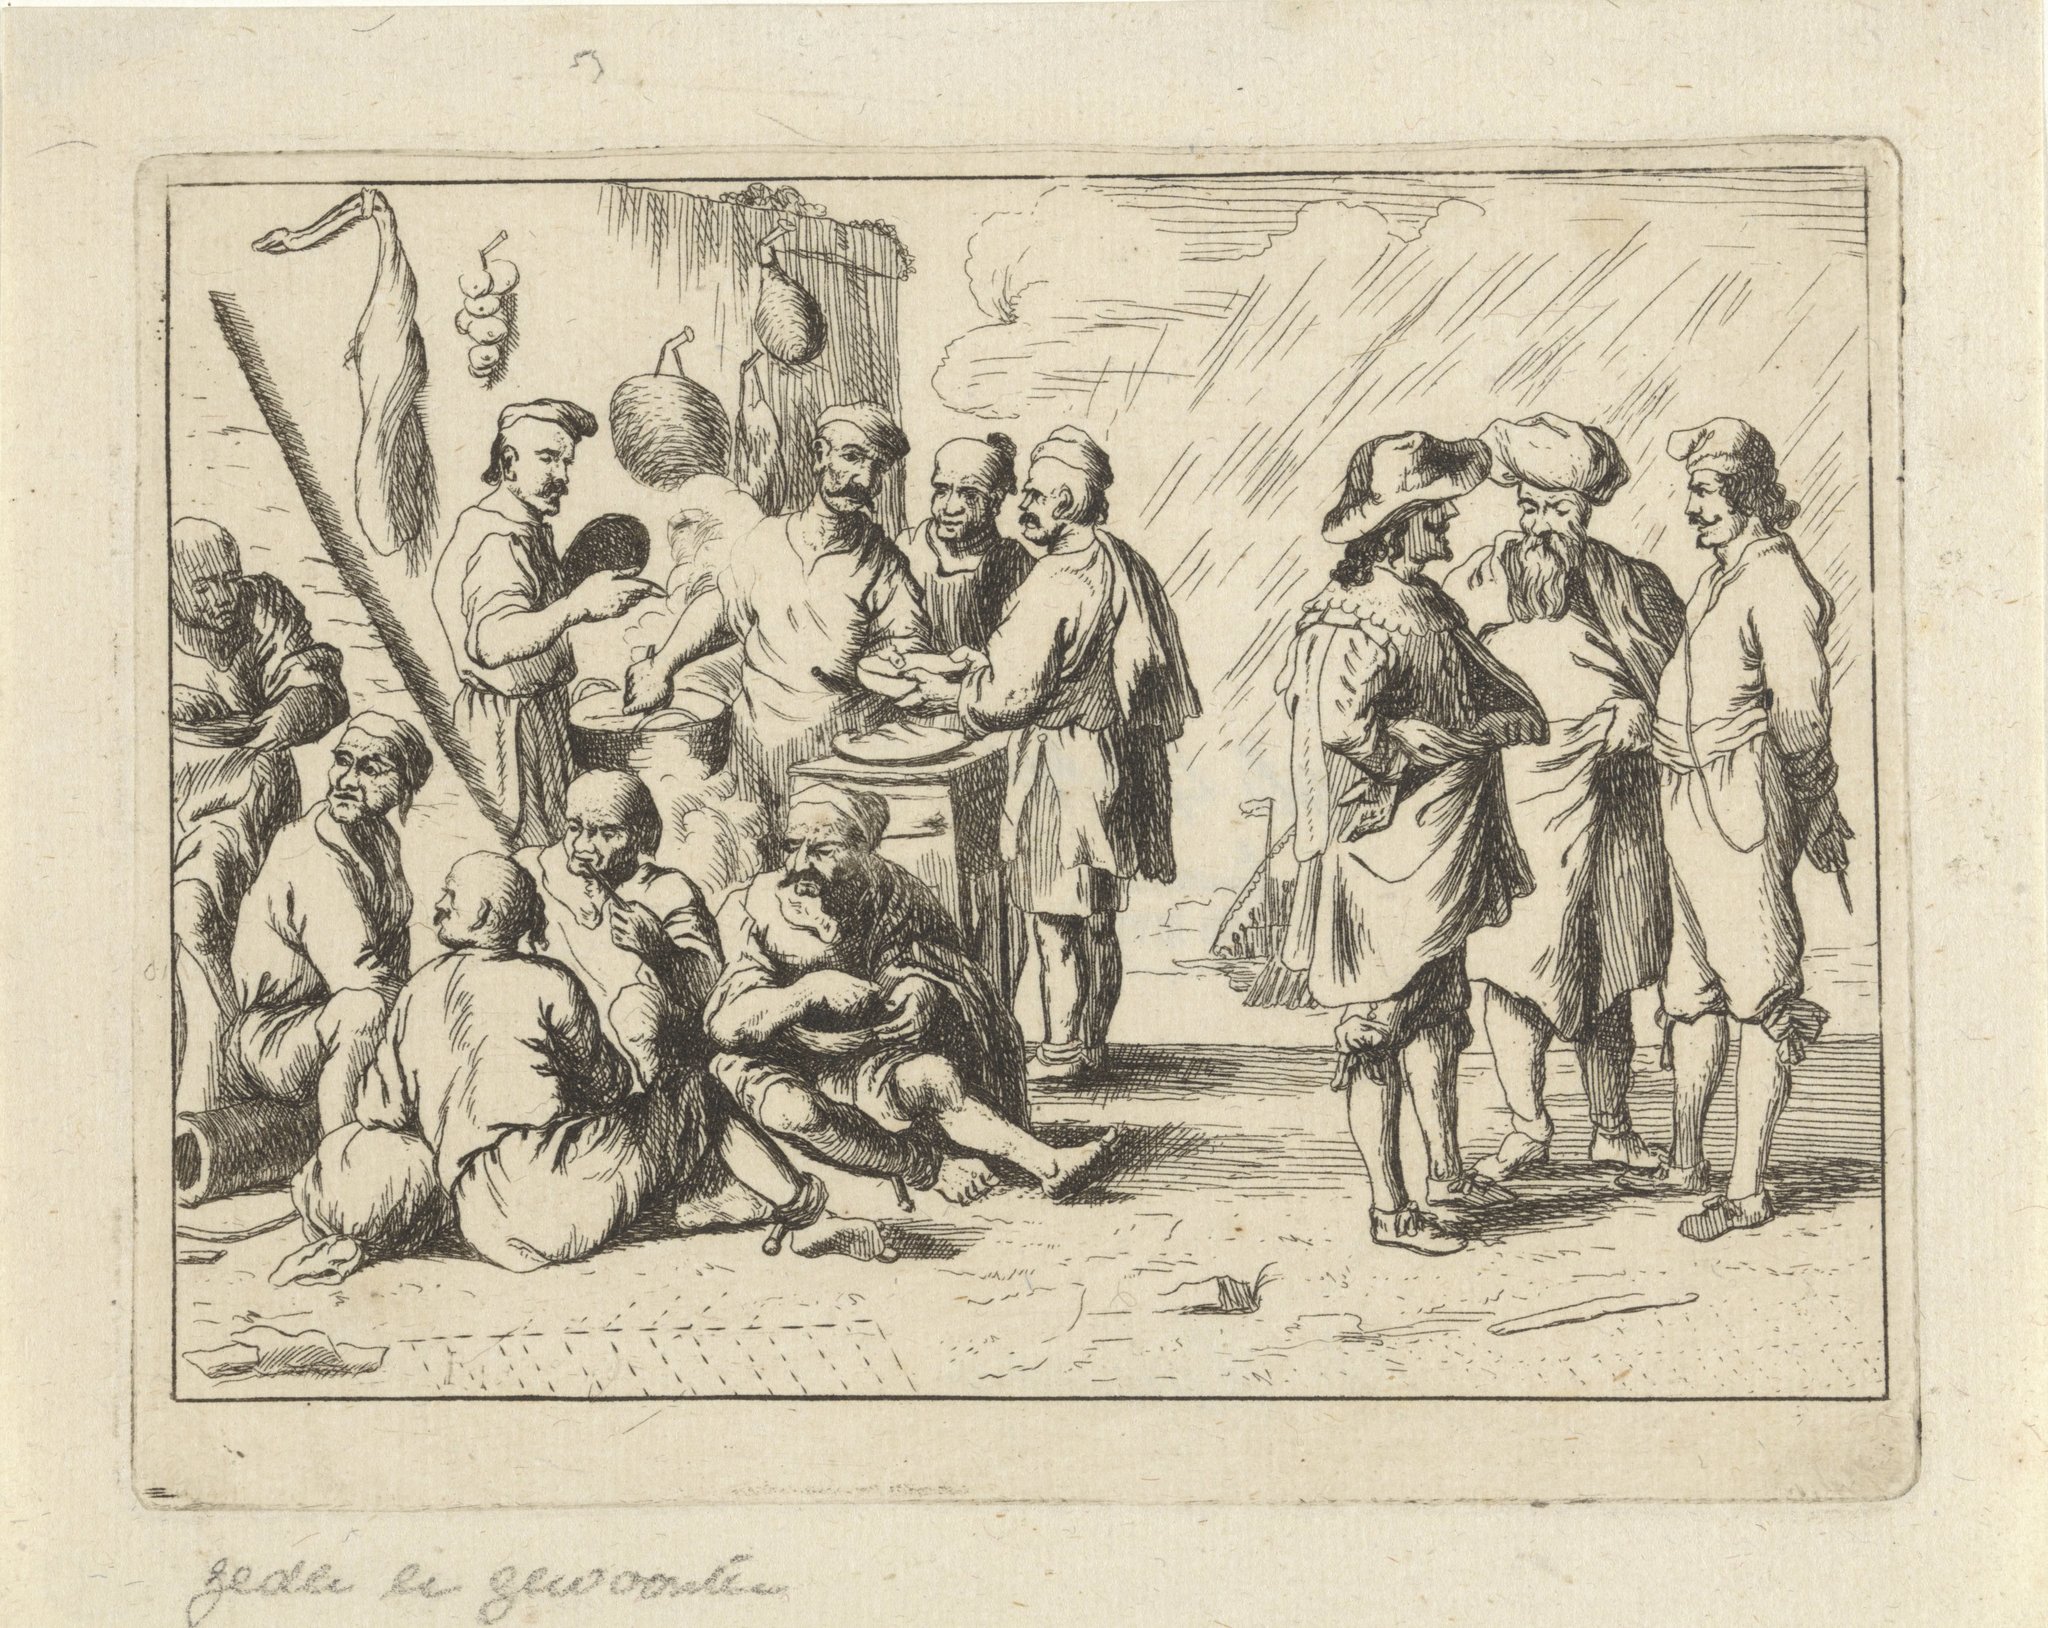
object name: print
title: Islamitische galeislaven in een Italiaanse haven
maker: m. schaep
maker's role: print maker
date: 1649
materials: paper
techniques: etching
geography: genoa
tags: harbour, kitchen-utensils: cauldron, soup-kitchen, cook-shop, slavery; serfs and enslaved persons, seaman: sailor, eating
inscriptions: collector's mark: Lugt 2228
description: Een kok roert in een ketel en deelt eten uit aan een groep islamitische galeislaven, de kok zelf behoort ook tot deze groep. Op de grond zit een aantal van hen te eten. Deze tot slaaf gemaakte mannen zijn als moslims te herkennen door het typerende kapsel (hoofd op een pluk na kaalgeschoren) dat zij verplicht waren te hebben. Rechts twee zeelieden in gesprek met een papasso (moellah en vertegenwoordiger van de islamitische tot slaaf gemaakten).